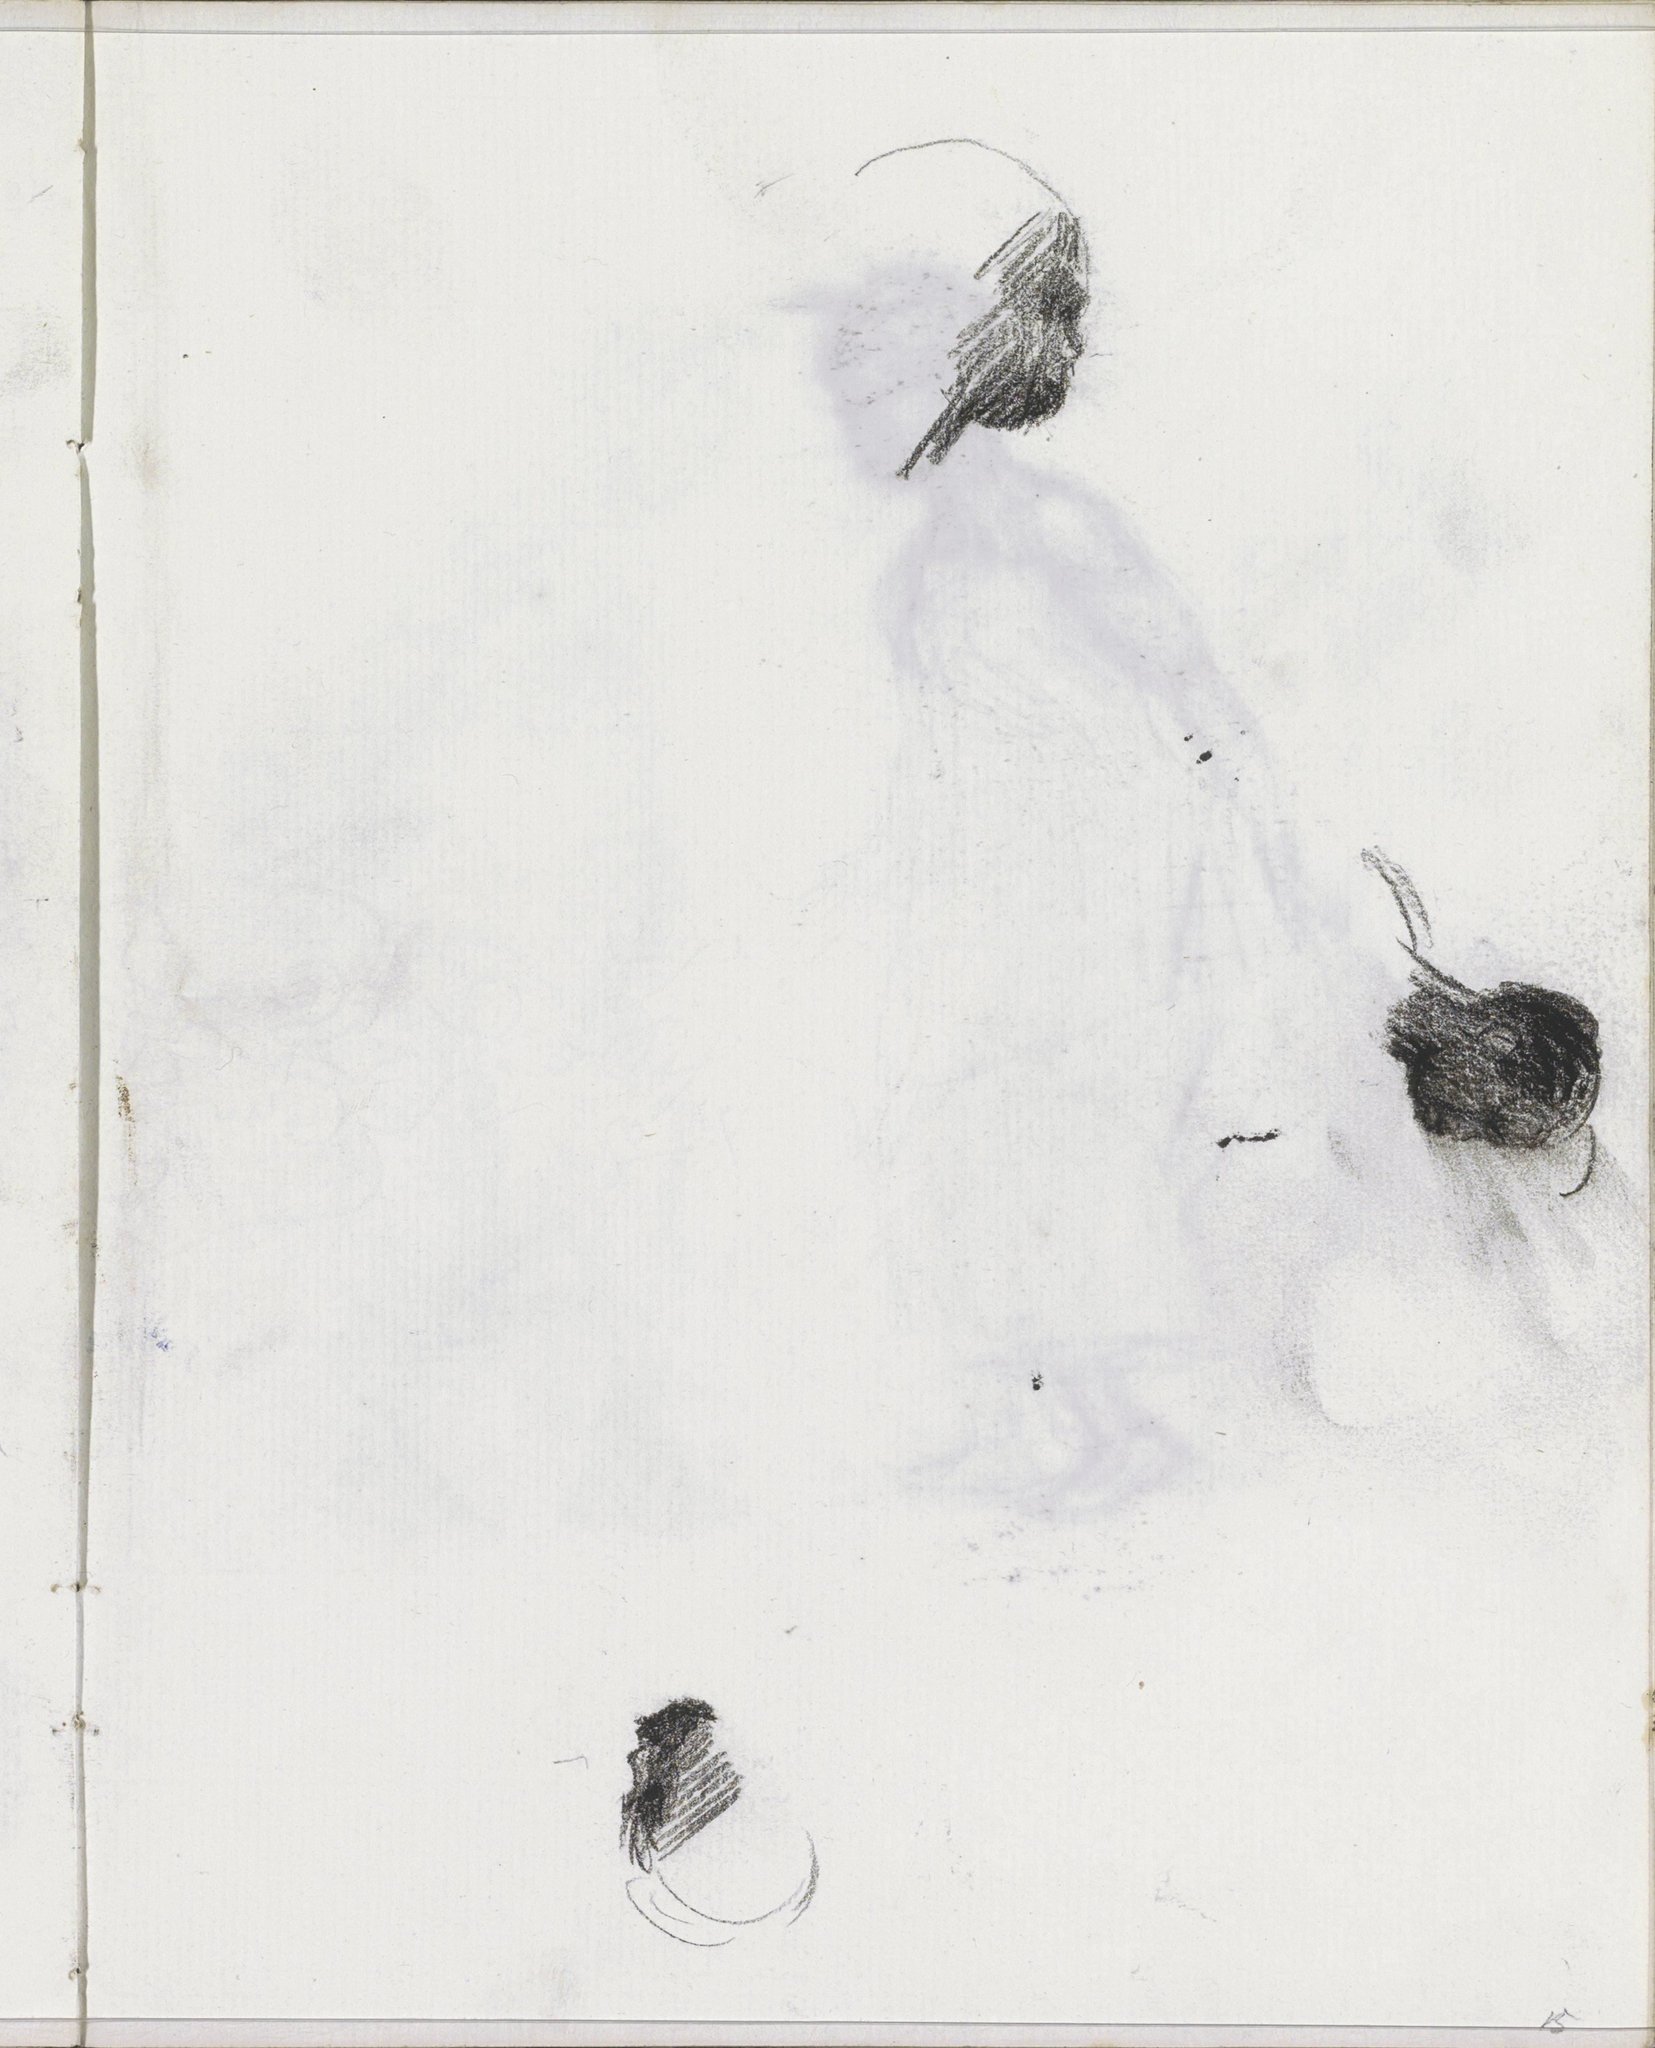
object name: sketchbook leaf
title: Hoofden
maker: isaac israels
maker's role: draughtsman, painter, print maker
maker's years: 1865-1934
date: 1875-1934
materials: chalk, paper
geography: the hague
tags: head (human), africans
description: Blad 15 recto uit schetsboek XIII met 25 bladen.